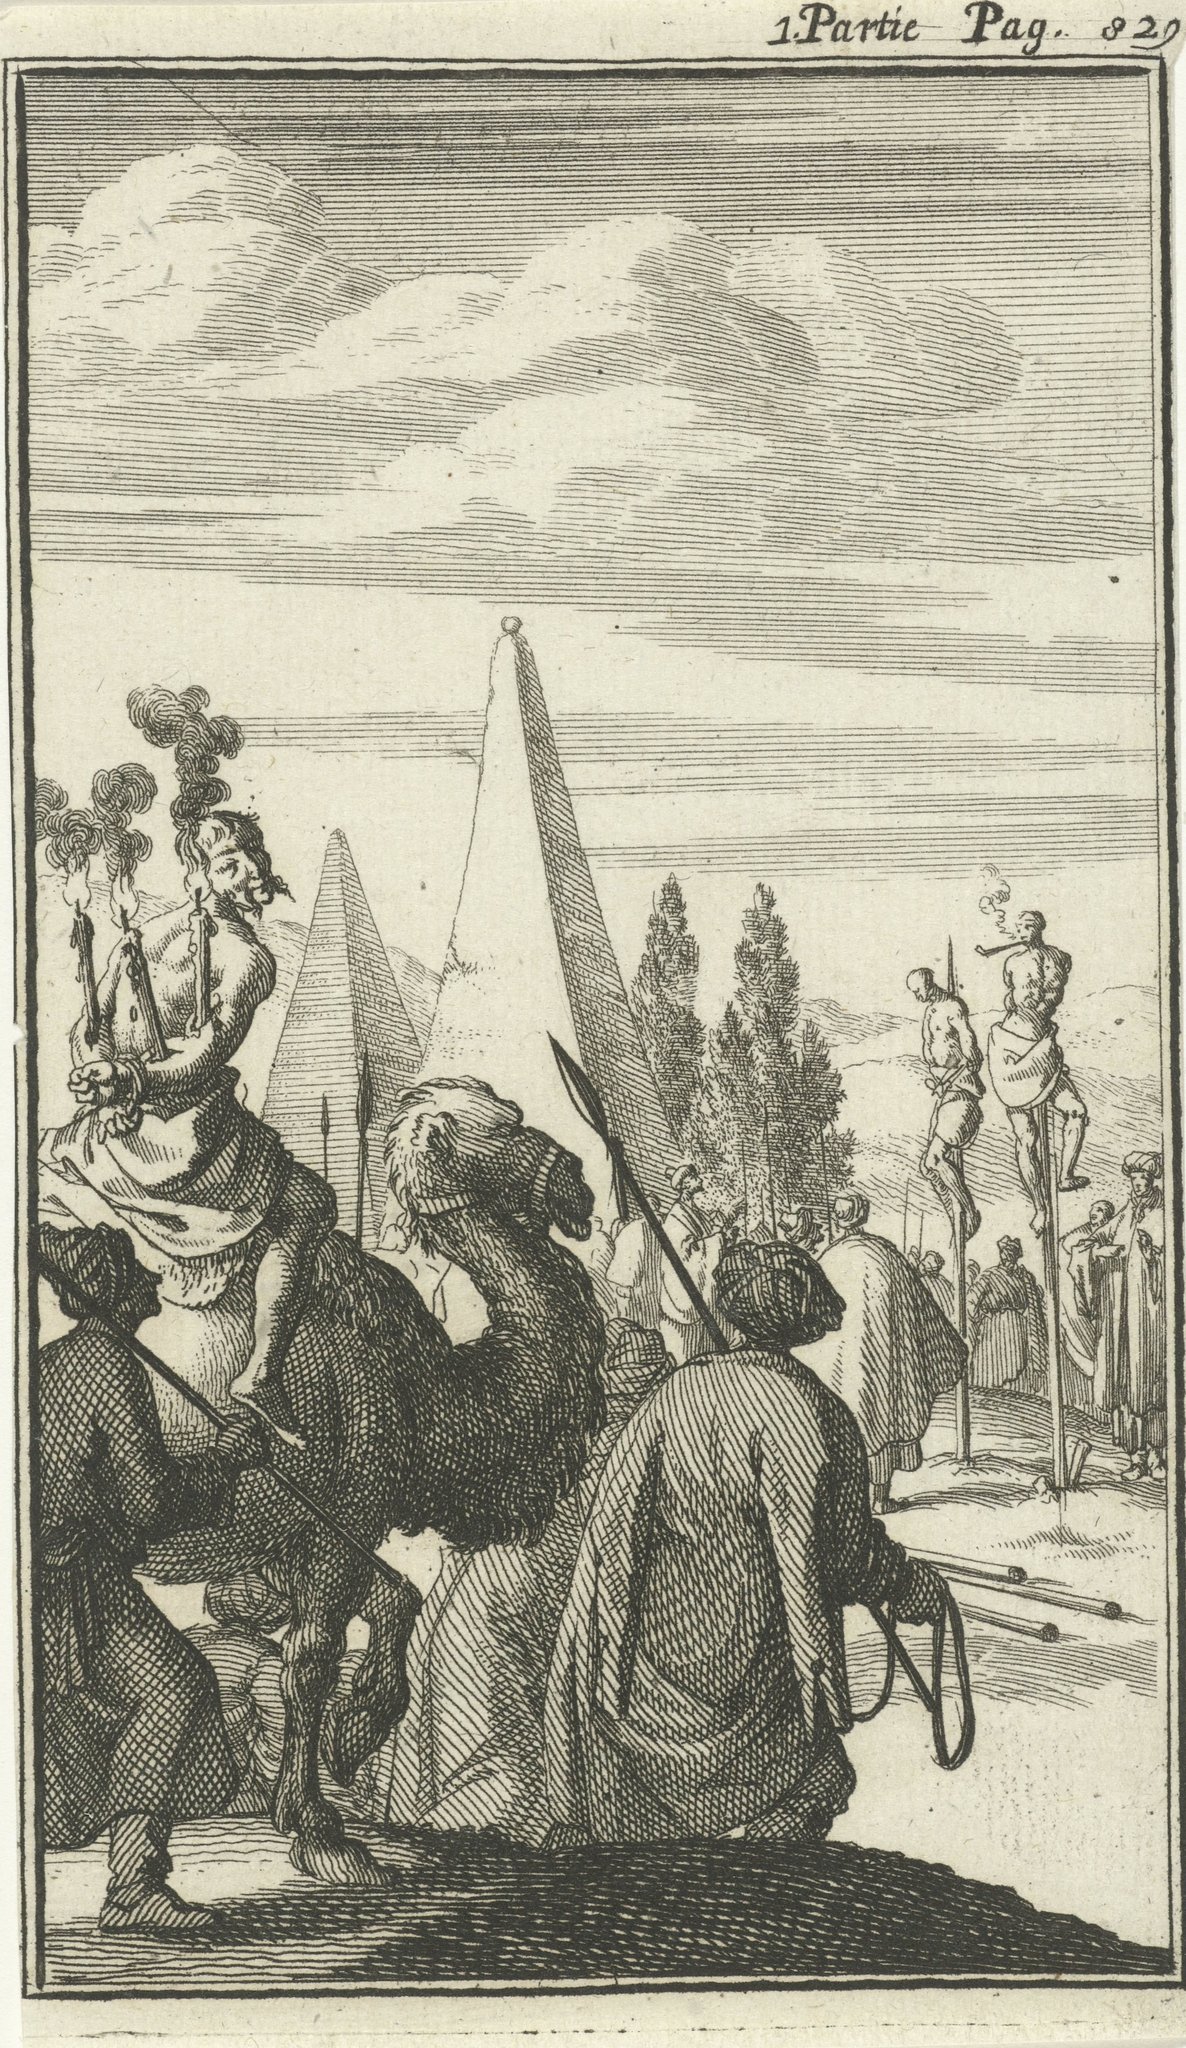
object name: print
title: Figuren voor straf aan een paal gespietst in Egypte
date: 1689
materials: paper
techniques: etching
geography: paris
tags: instruments of torture, execution or punishment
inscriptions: collector's mark: Lugt 2228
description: Illustratie uit: Thevenot, Jean de. Voyages Tant en Europe qu'en Asie et en Afrique, 4 delen. Parijs: Charles Angot, 1689, dl. II.